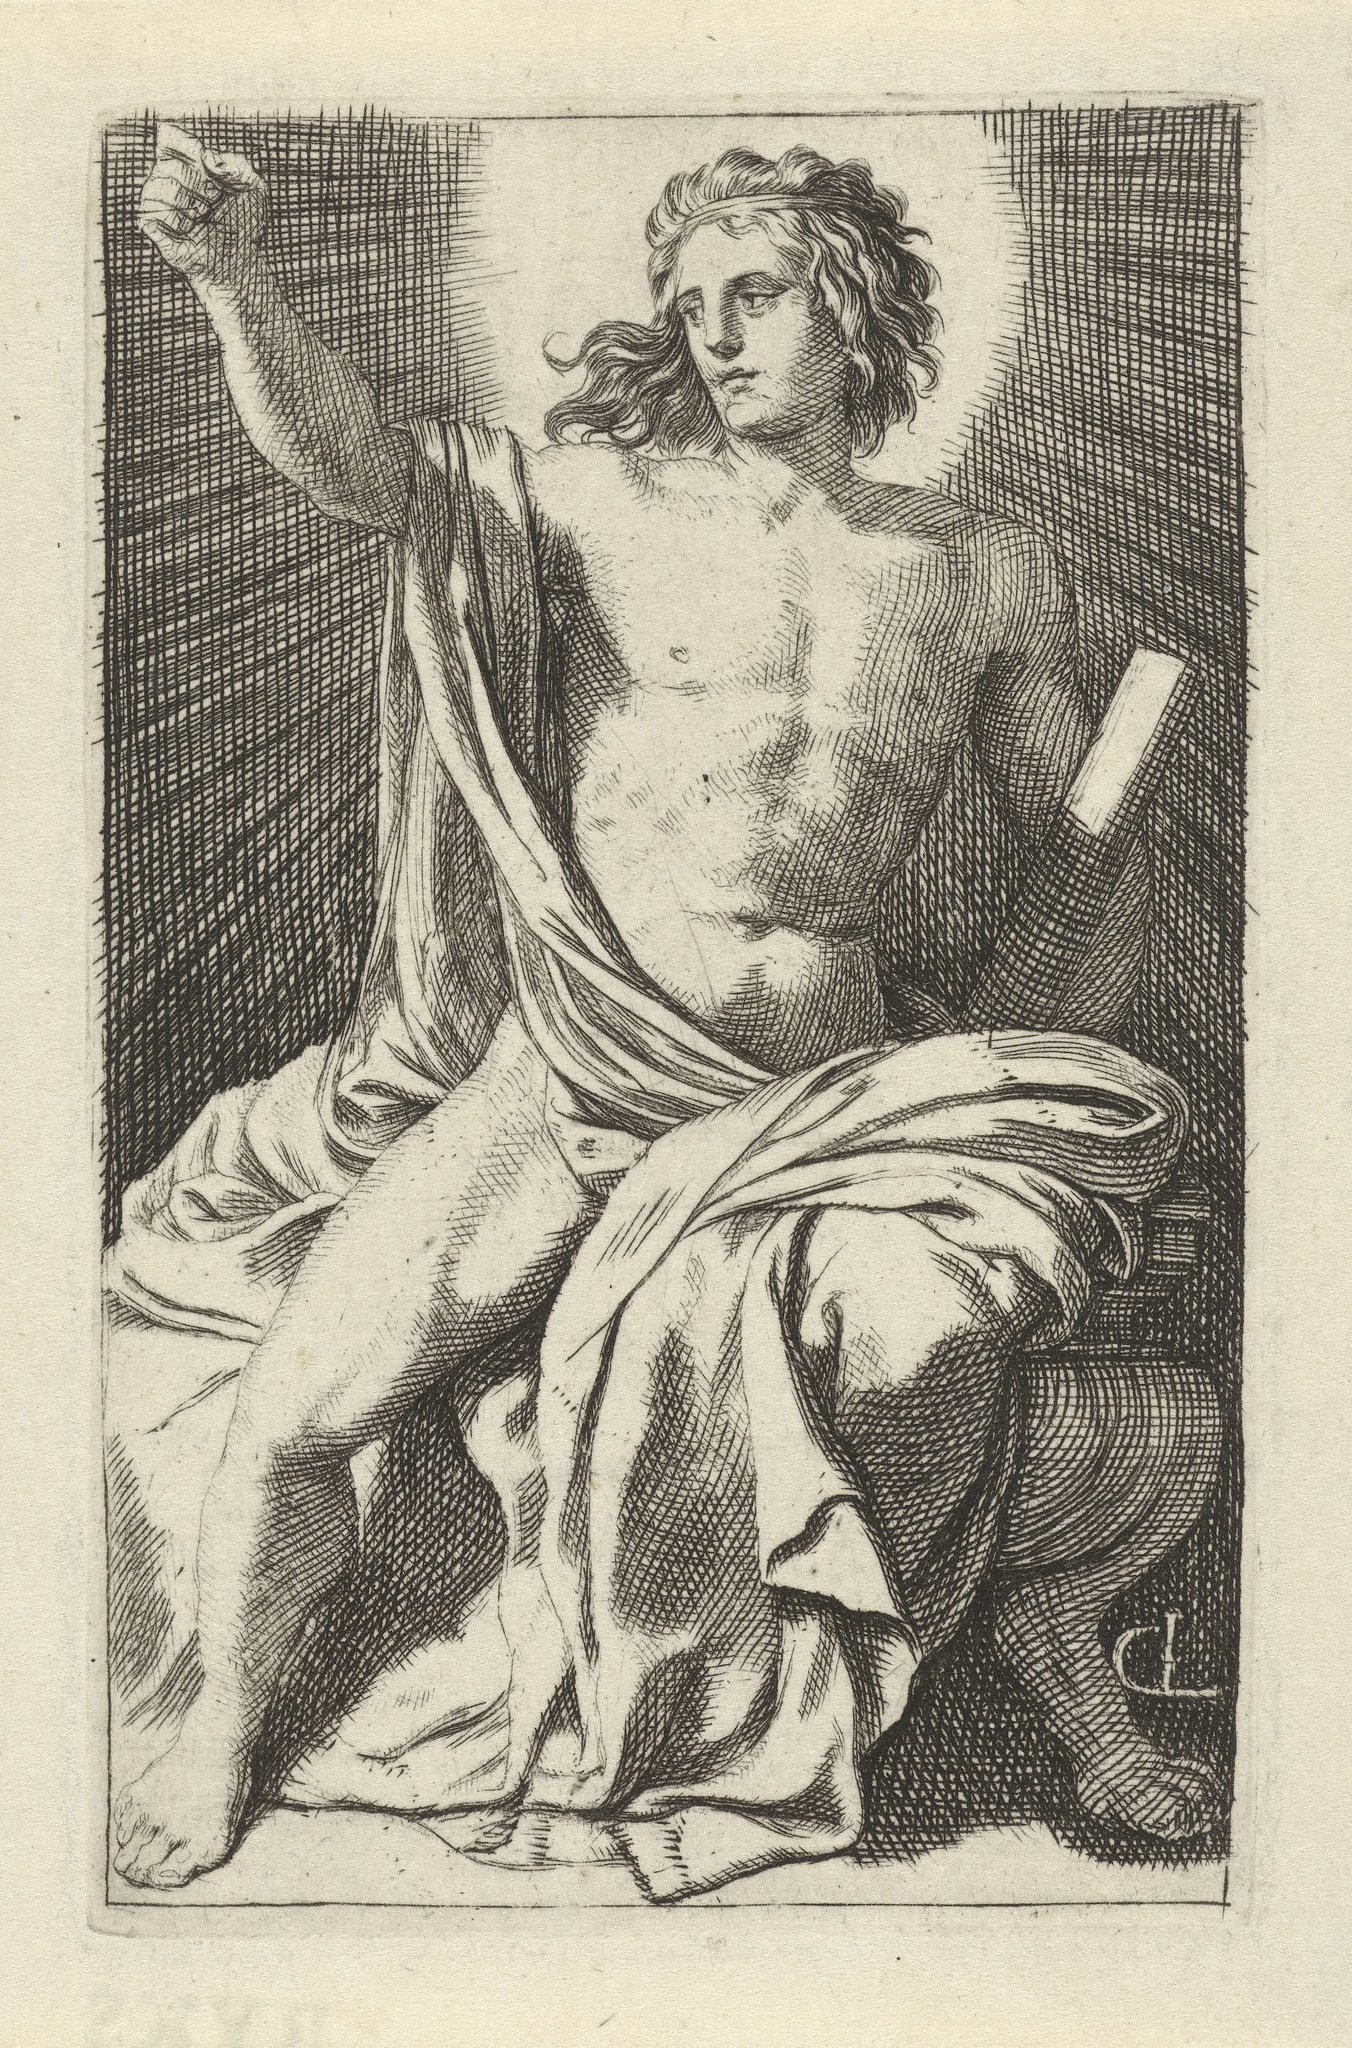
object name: print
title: Apollo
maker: gerard de lairesse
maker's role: draughtsman, painter, print maker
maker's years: 1641-1711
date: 1670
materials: paper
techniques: etching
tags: specific aspects, allegorical aspects of apollo; apollo as patron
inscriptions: collector's mark: Lugt 2165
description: Apollo als god van de zon. Zijn hoofd is omgeven door een krans van stralend licht, zijn rechter vuist heeft Apollo in de lucht geheven.